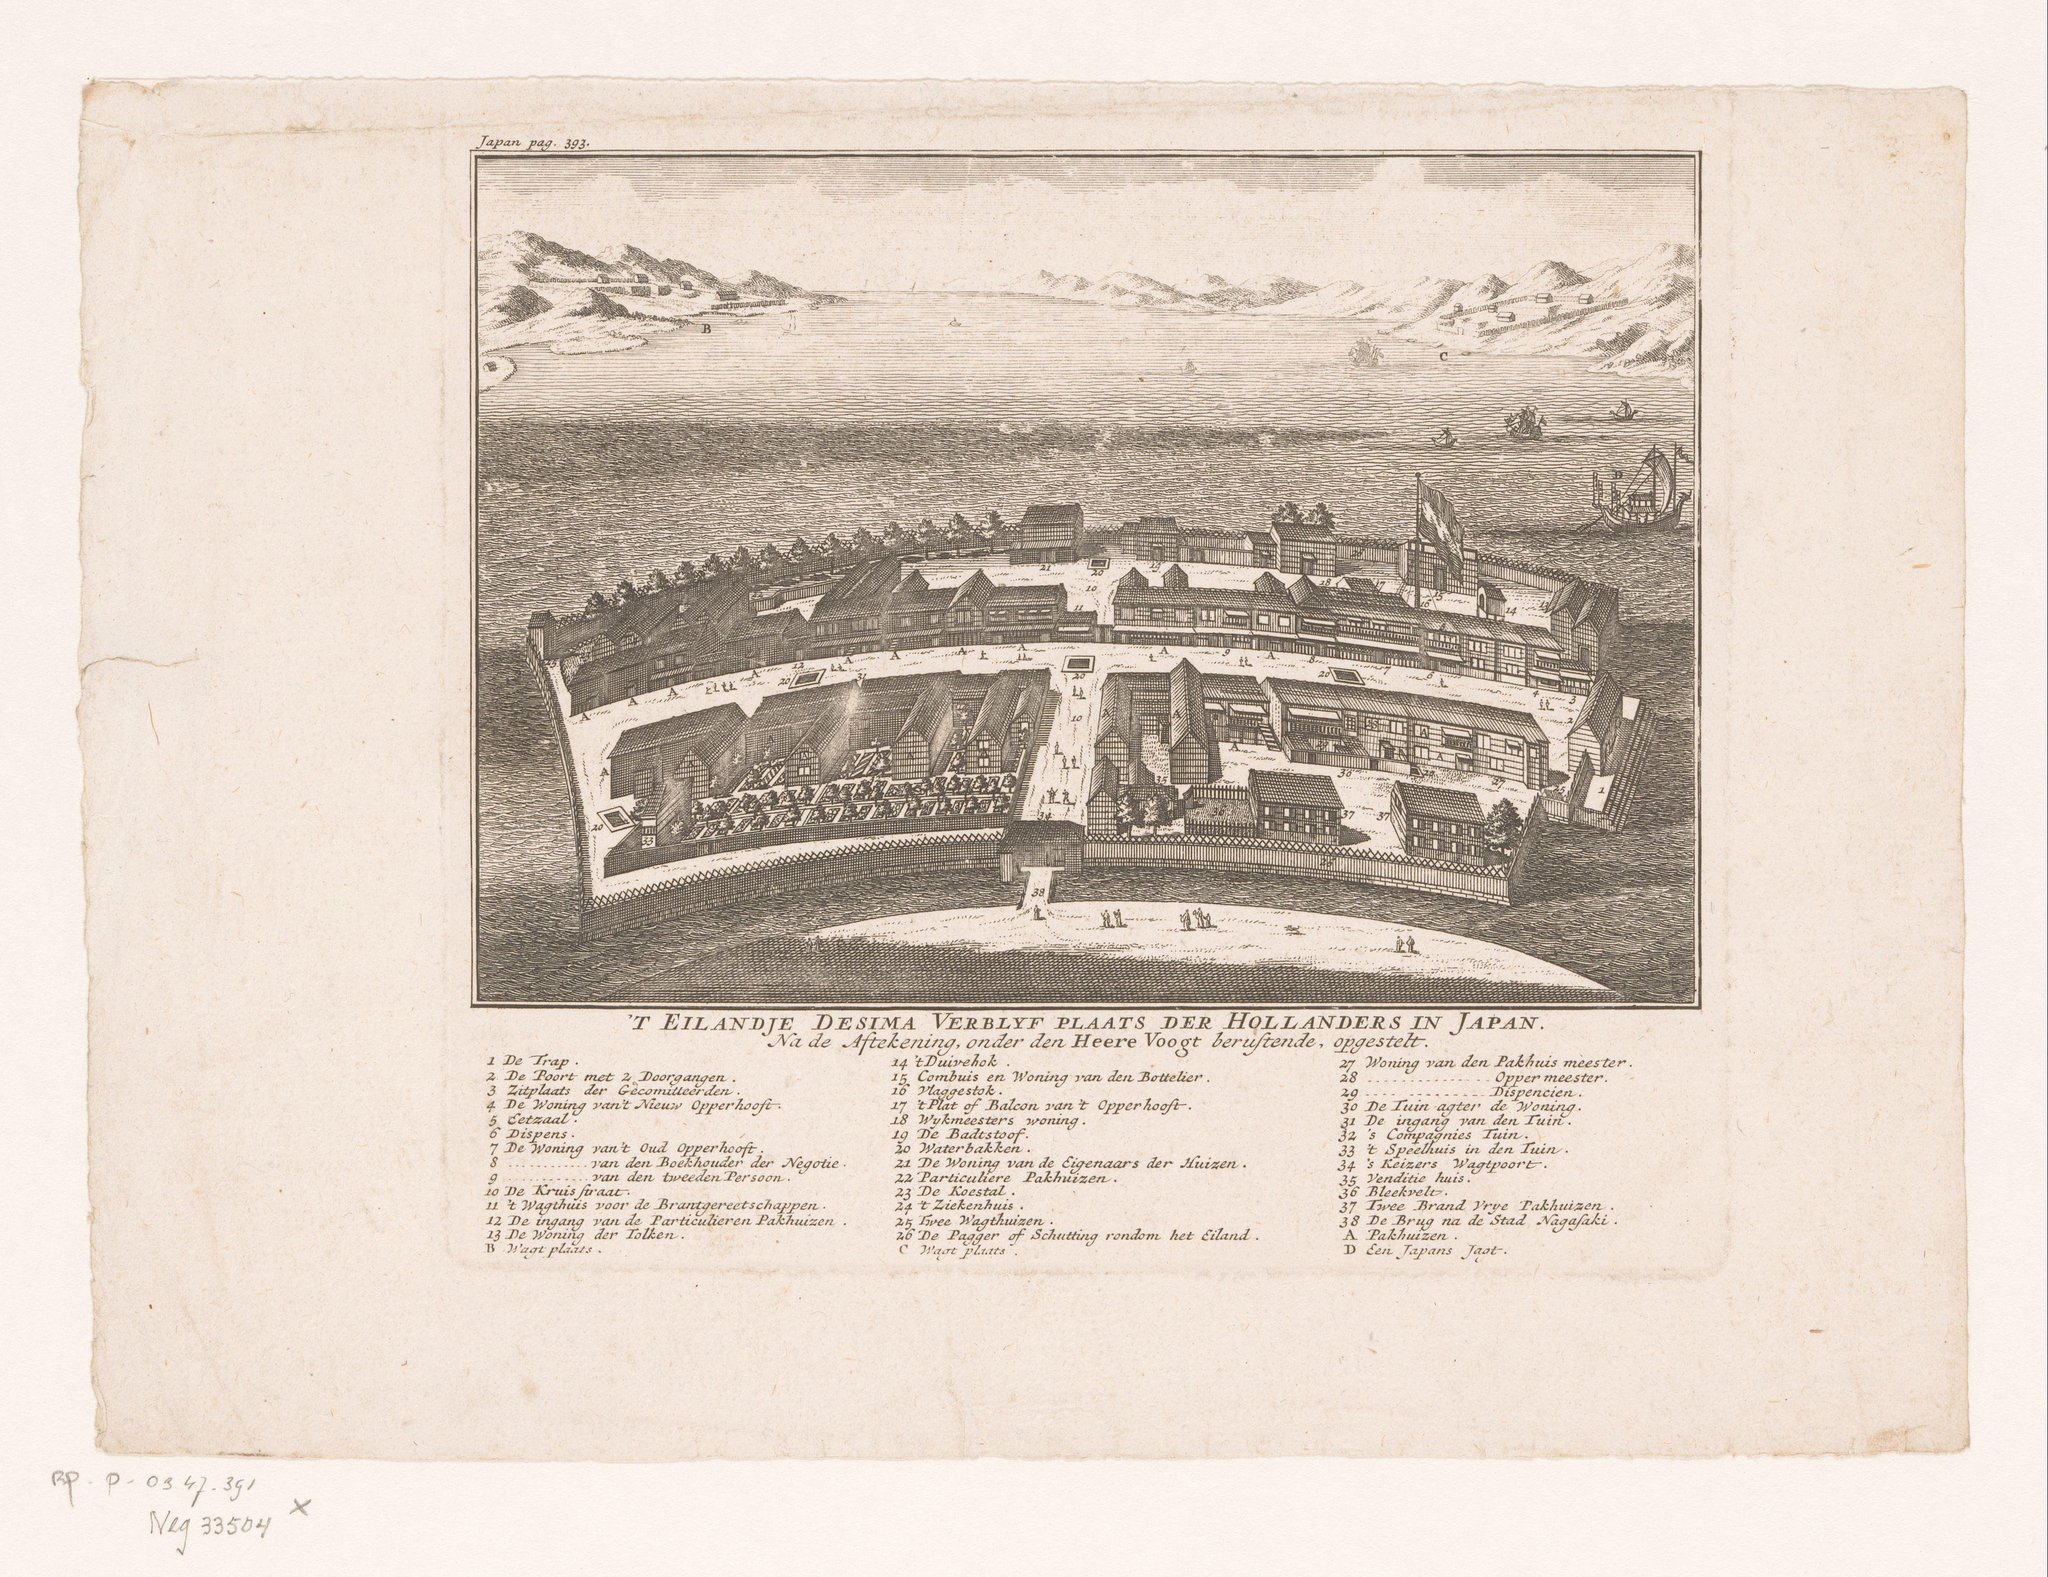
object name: book illustration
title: Gezicht in vogelvluchtperspectief op Dejima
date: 1729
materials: paper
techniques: engraving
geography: amsterdam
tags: maps of cities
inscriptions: collector's mark: Lugt 2228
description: uit: Salmon, Th. Hedendaegsche historie, of tegenwoordige staat (...), 22 dln. Amsterdam: Isaak Tirion, 1729-1772, dl. 1, p. 393.